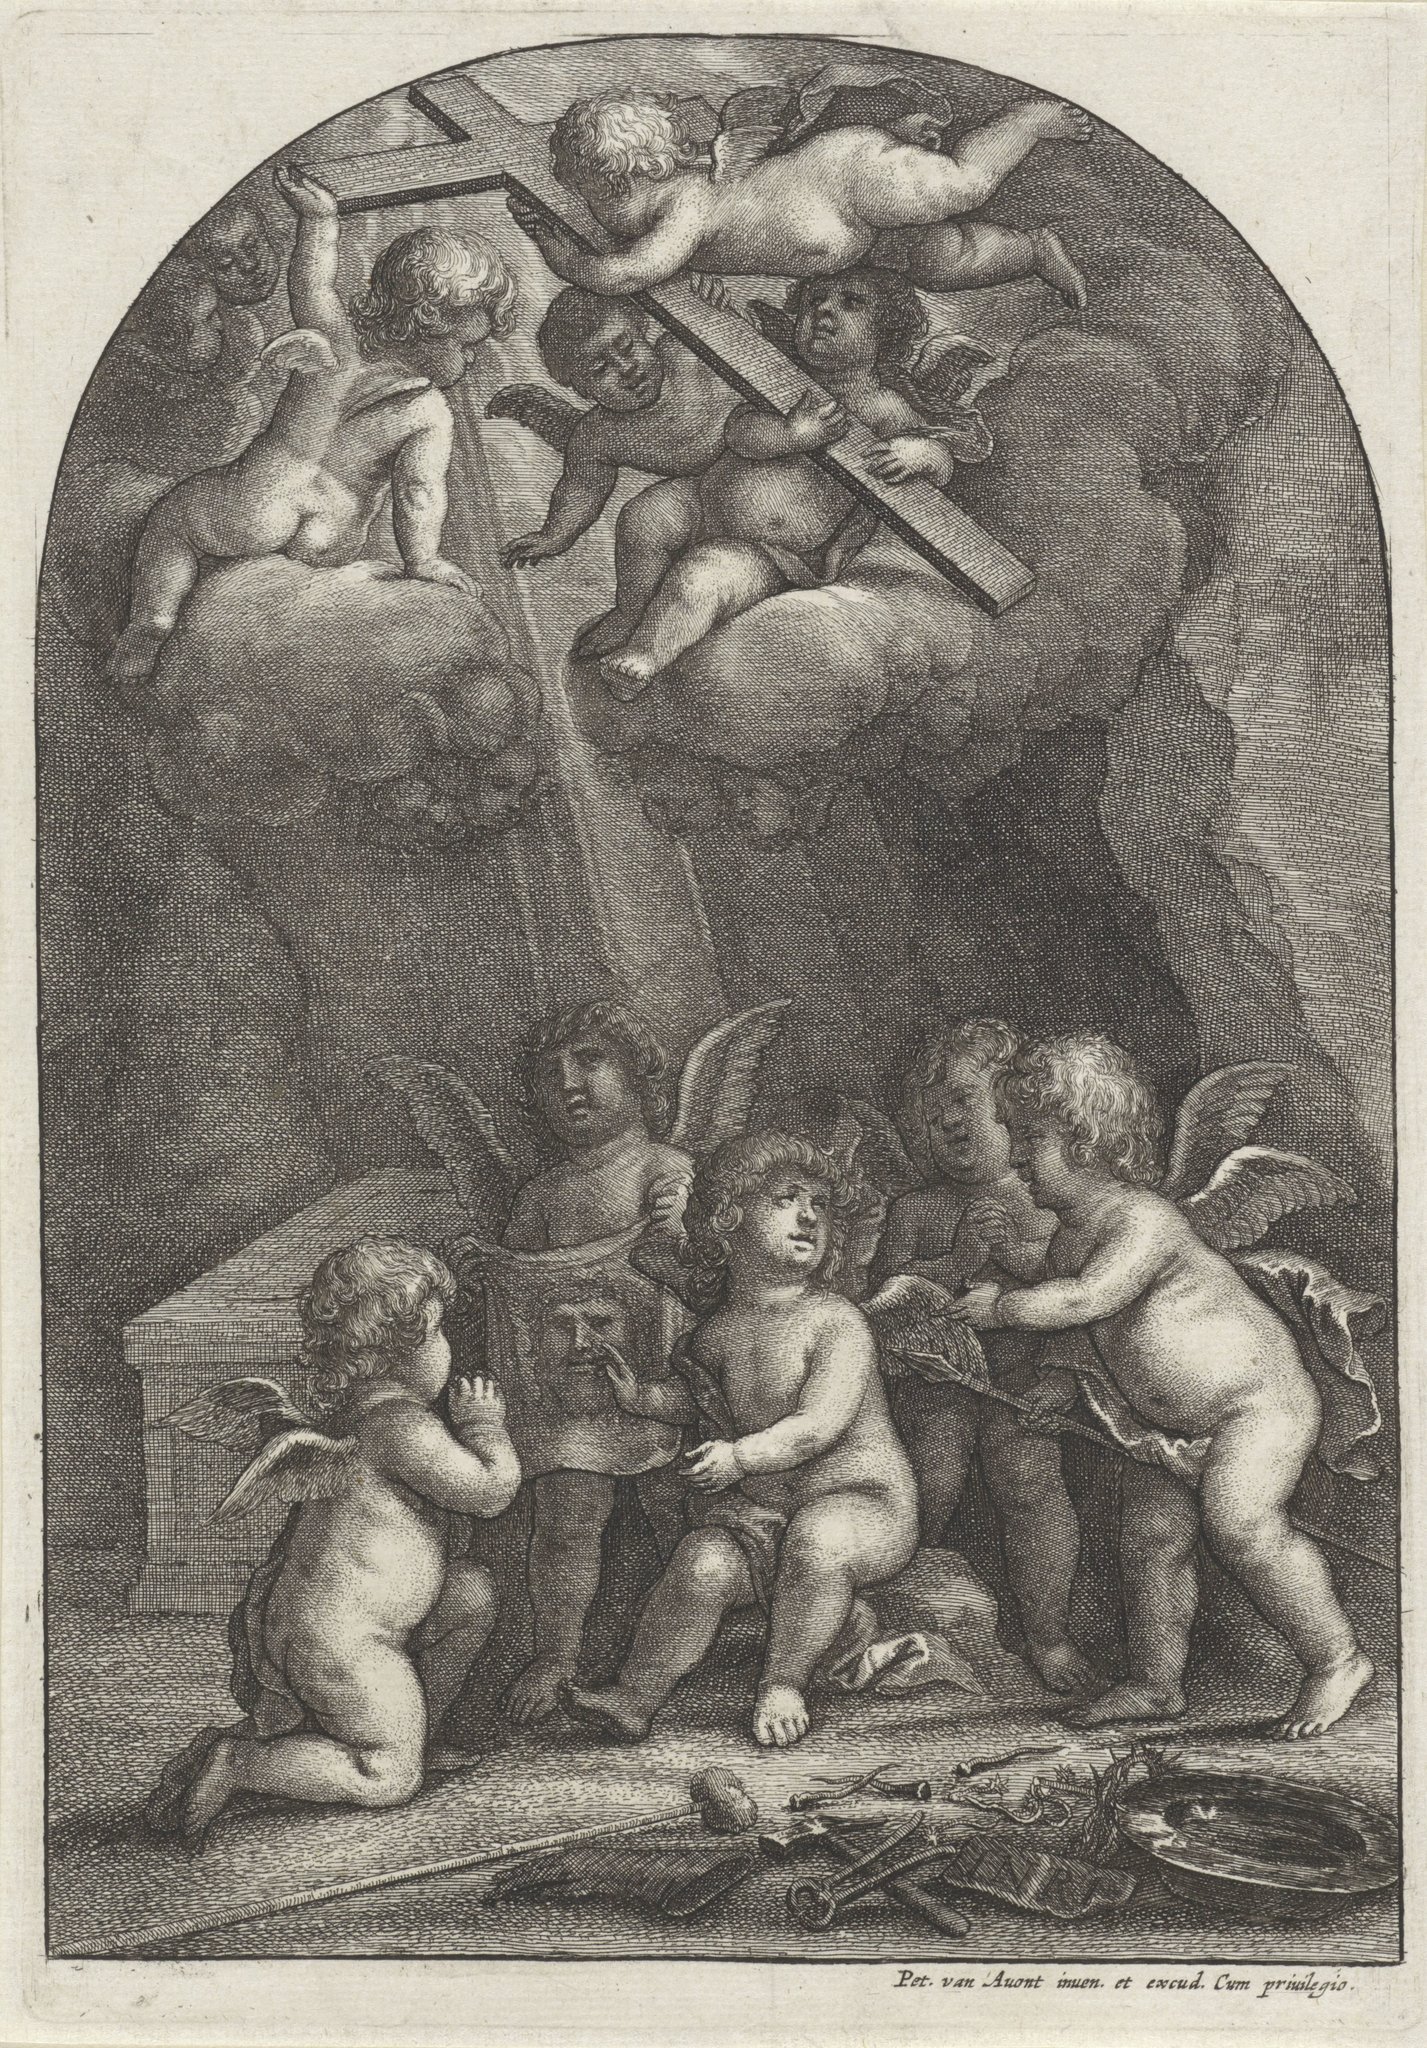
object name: print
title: Putti met passiewerktuigen bij het graf van Christus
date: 1644-1652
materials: paper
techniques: etching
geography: antwerp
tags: 'arma christi'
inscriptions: collector's mark: Lugt 240